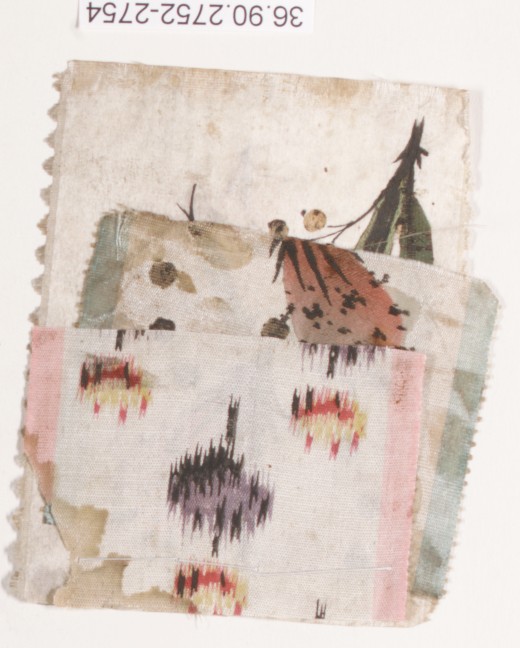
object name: ribbon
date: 1801-1900